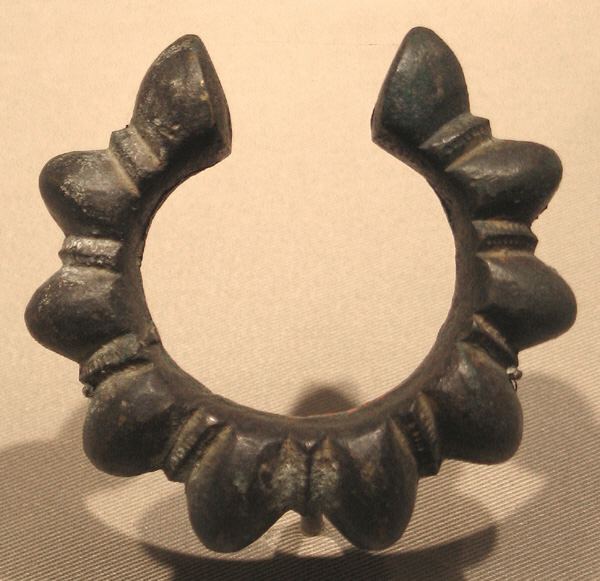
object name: bangle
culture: indian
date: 801-1000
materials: bronze